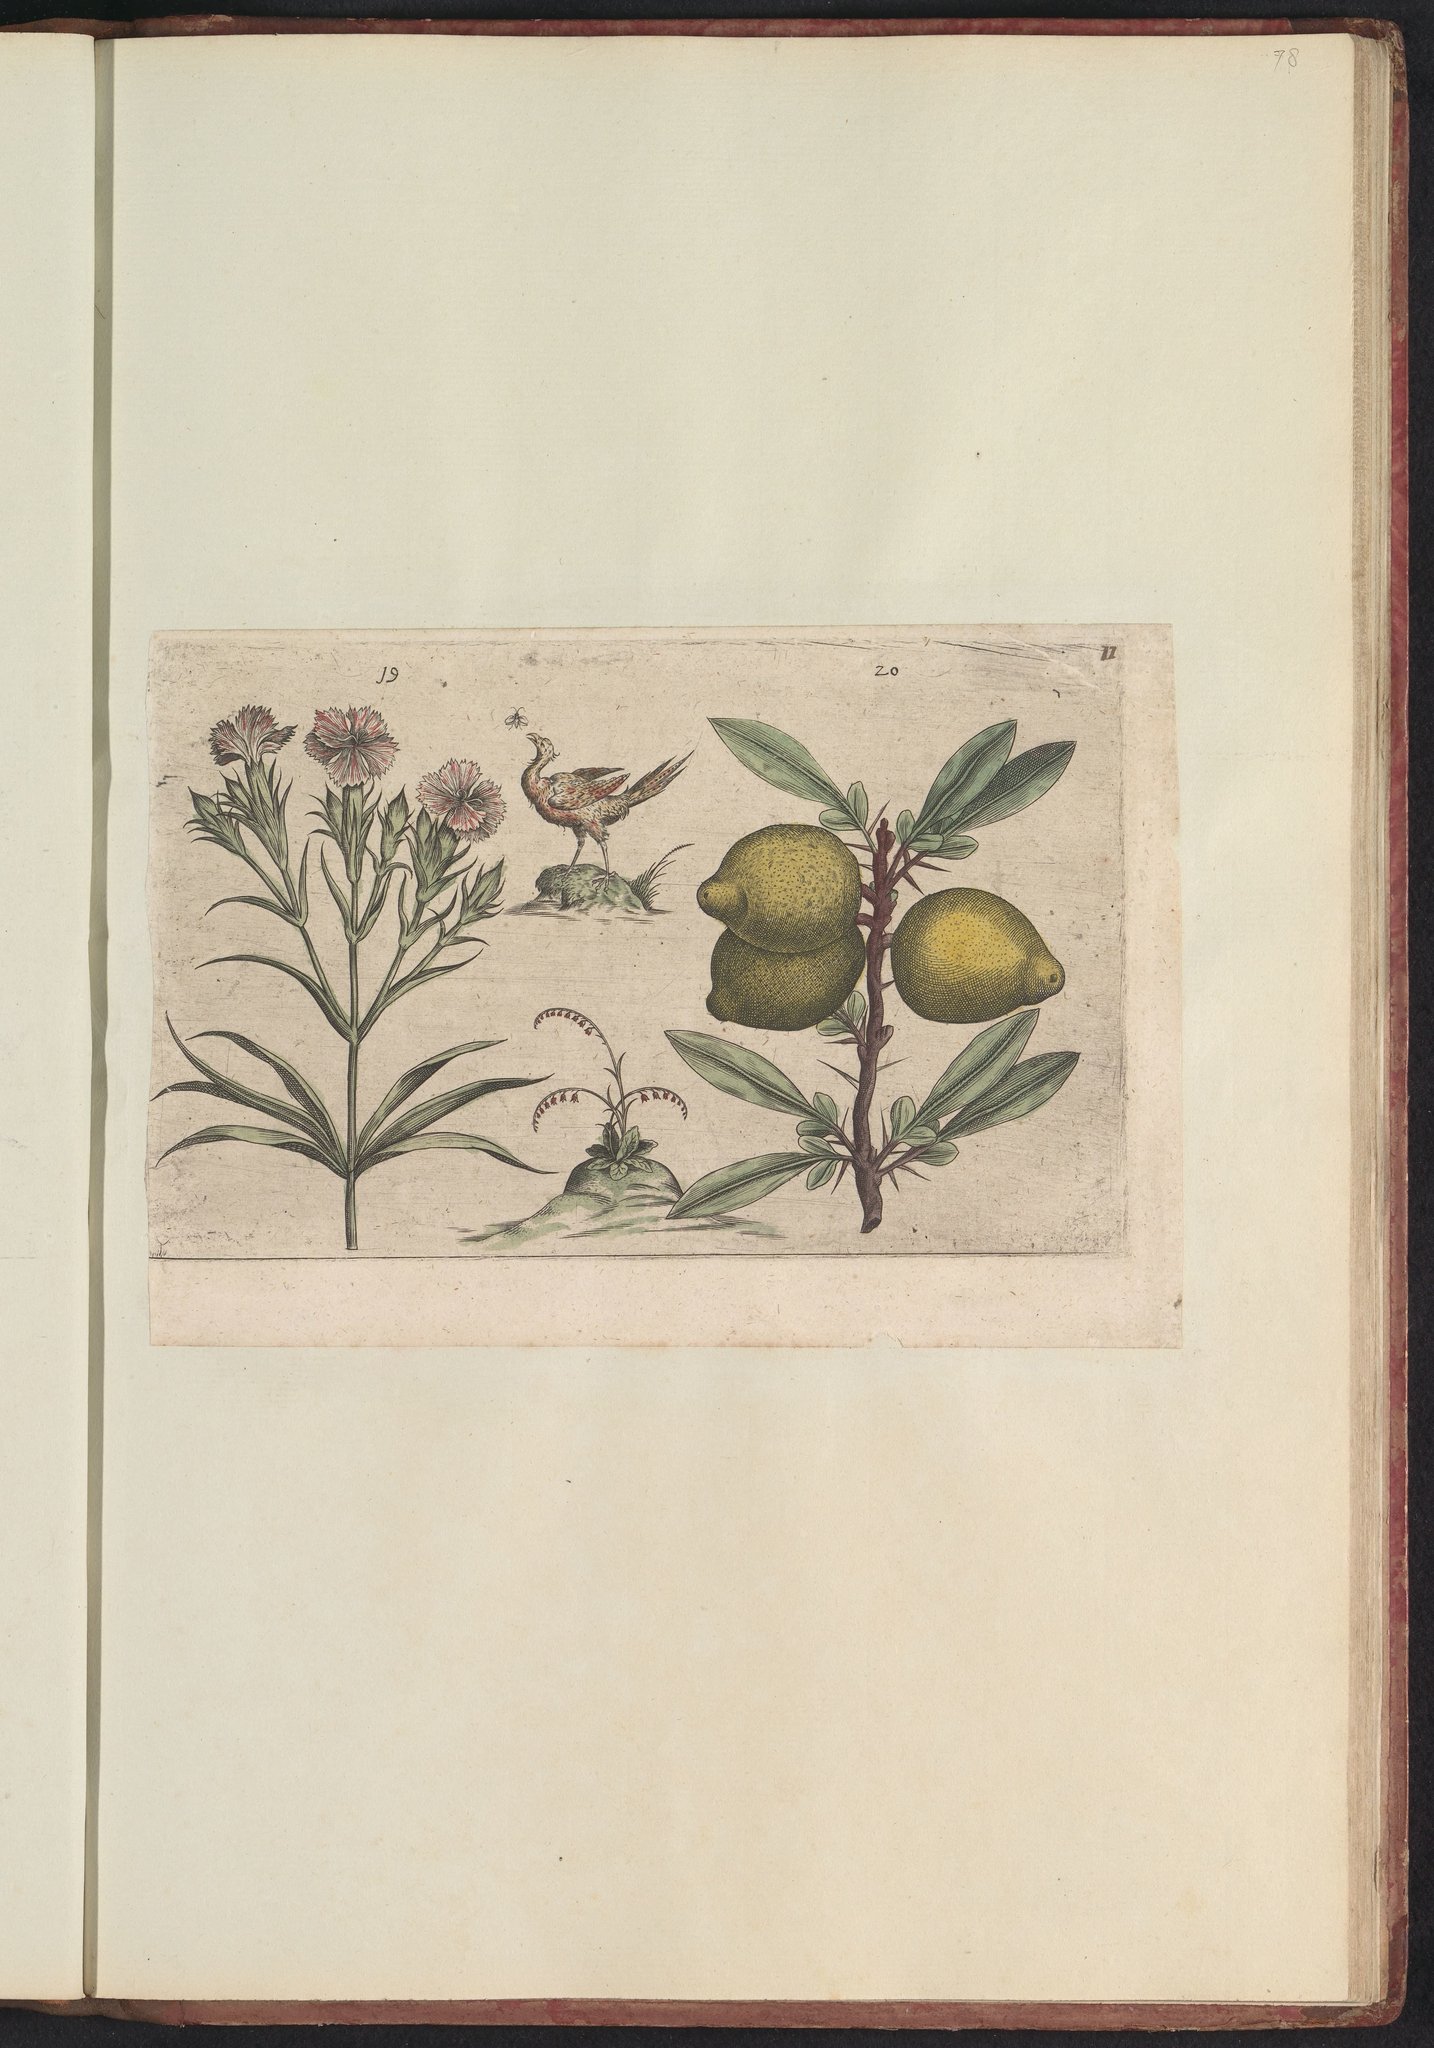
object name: print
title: Tuinanjers (Dianthus caryophyllus) en citroenen (Citrus limon)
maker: Anonymous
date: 1604-1632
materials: ink, paper, watercolor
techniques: engraving, hand coloring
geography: southern netherlands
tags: flowers: carnation, fruits: lemon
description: Tuinanjers en (doornige) citroenen. Met een vogel die naar een vlieg hapt en een kleine ornamentele plant. Figs. 19 en 20 op een blad met de hand genummerd 11. In: Anselmi Boëtii de Boot I.C. Brugensis & Rodolphi II. Imp. Roman. medici a cubiculis Florum, Herbarum, ac fructuum selectiorum icones, & vires pleraeque hactenus ignotæ. Onderdeel van het album met bladen en platen uit De Boodts herbarium van 1640. Het twaalfde van twaalf albums met aquarellen van dieren, vogels en planten bekend rond 1600, gemaakt in opdracht van keizer Rudolf II.